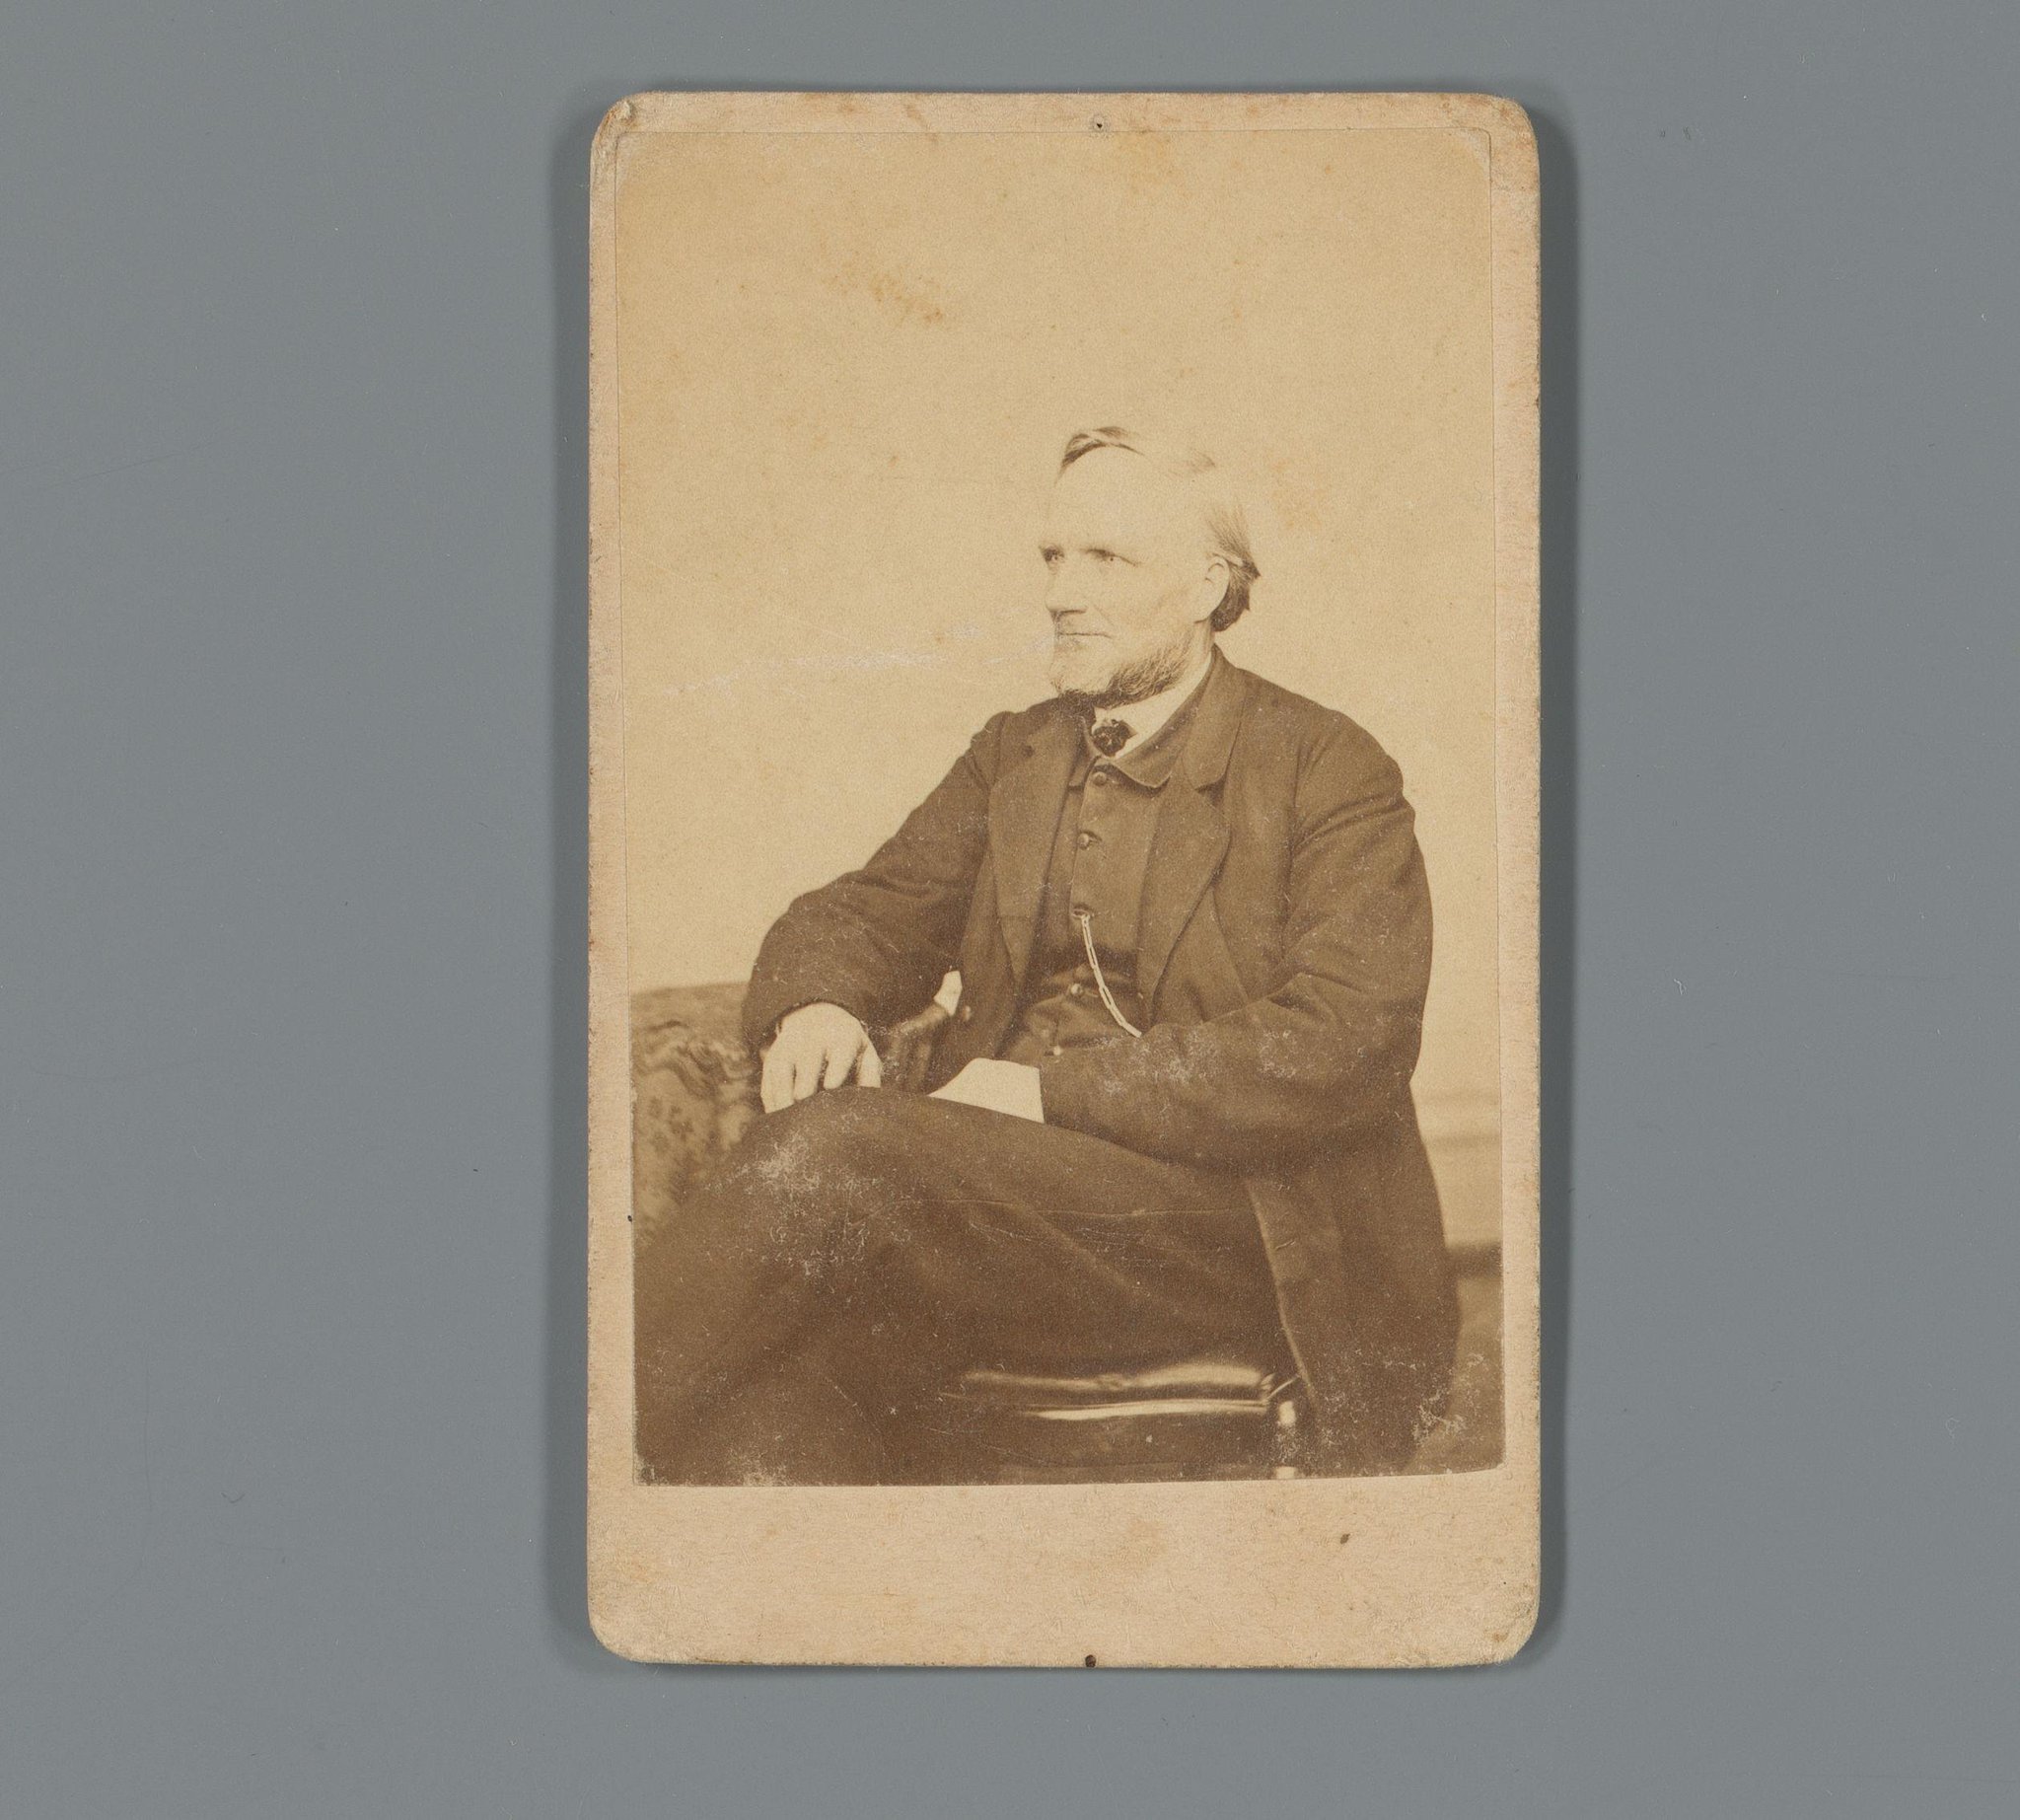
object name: carte de visite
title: Portret van Henry Plummer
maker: Anonymous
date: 1850-1915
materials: cardboard, photographic support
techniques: albumen print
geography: maine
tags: historical persons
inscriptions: inscription: ‘H. PLUMMER/ WILL SELL/ DRY GOODS, At Wholesale & Retail./ CHEAPER/ Than any other man/ In this Country./ Try me./ Skowhegan, Me.’